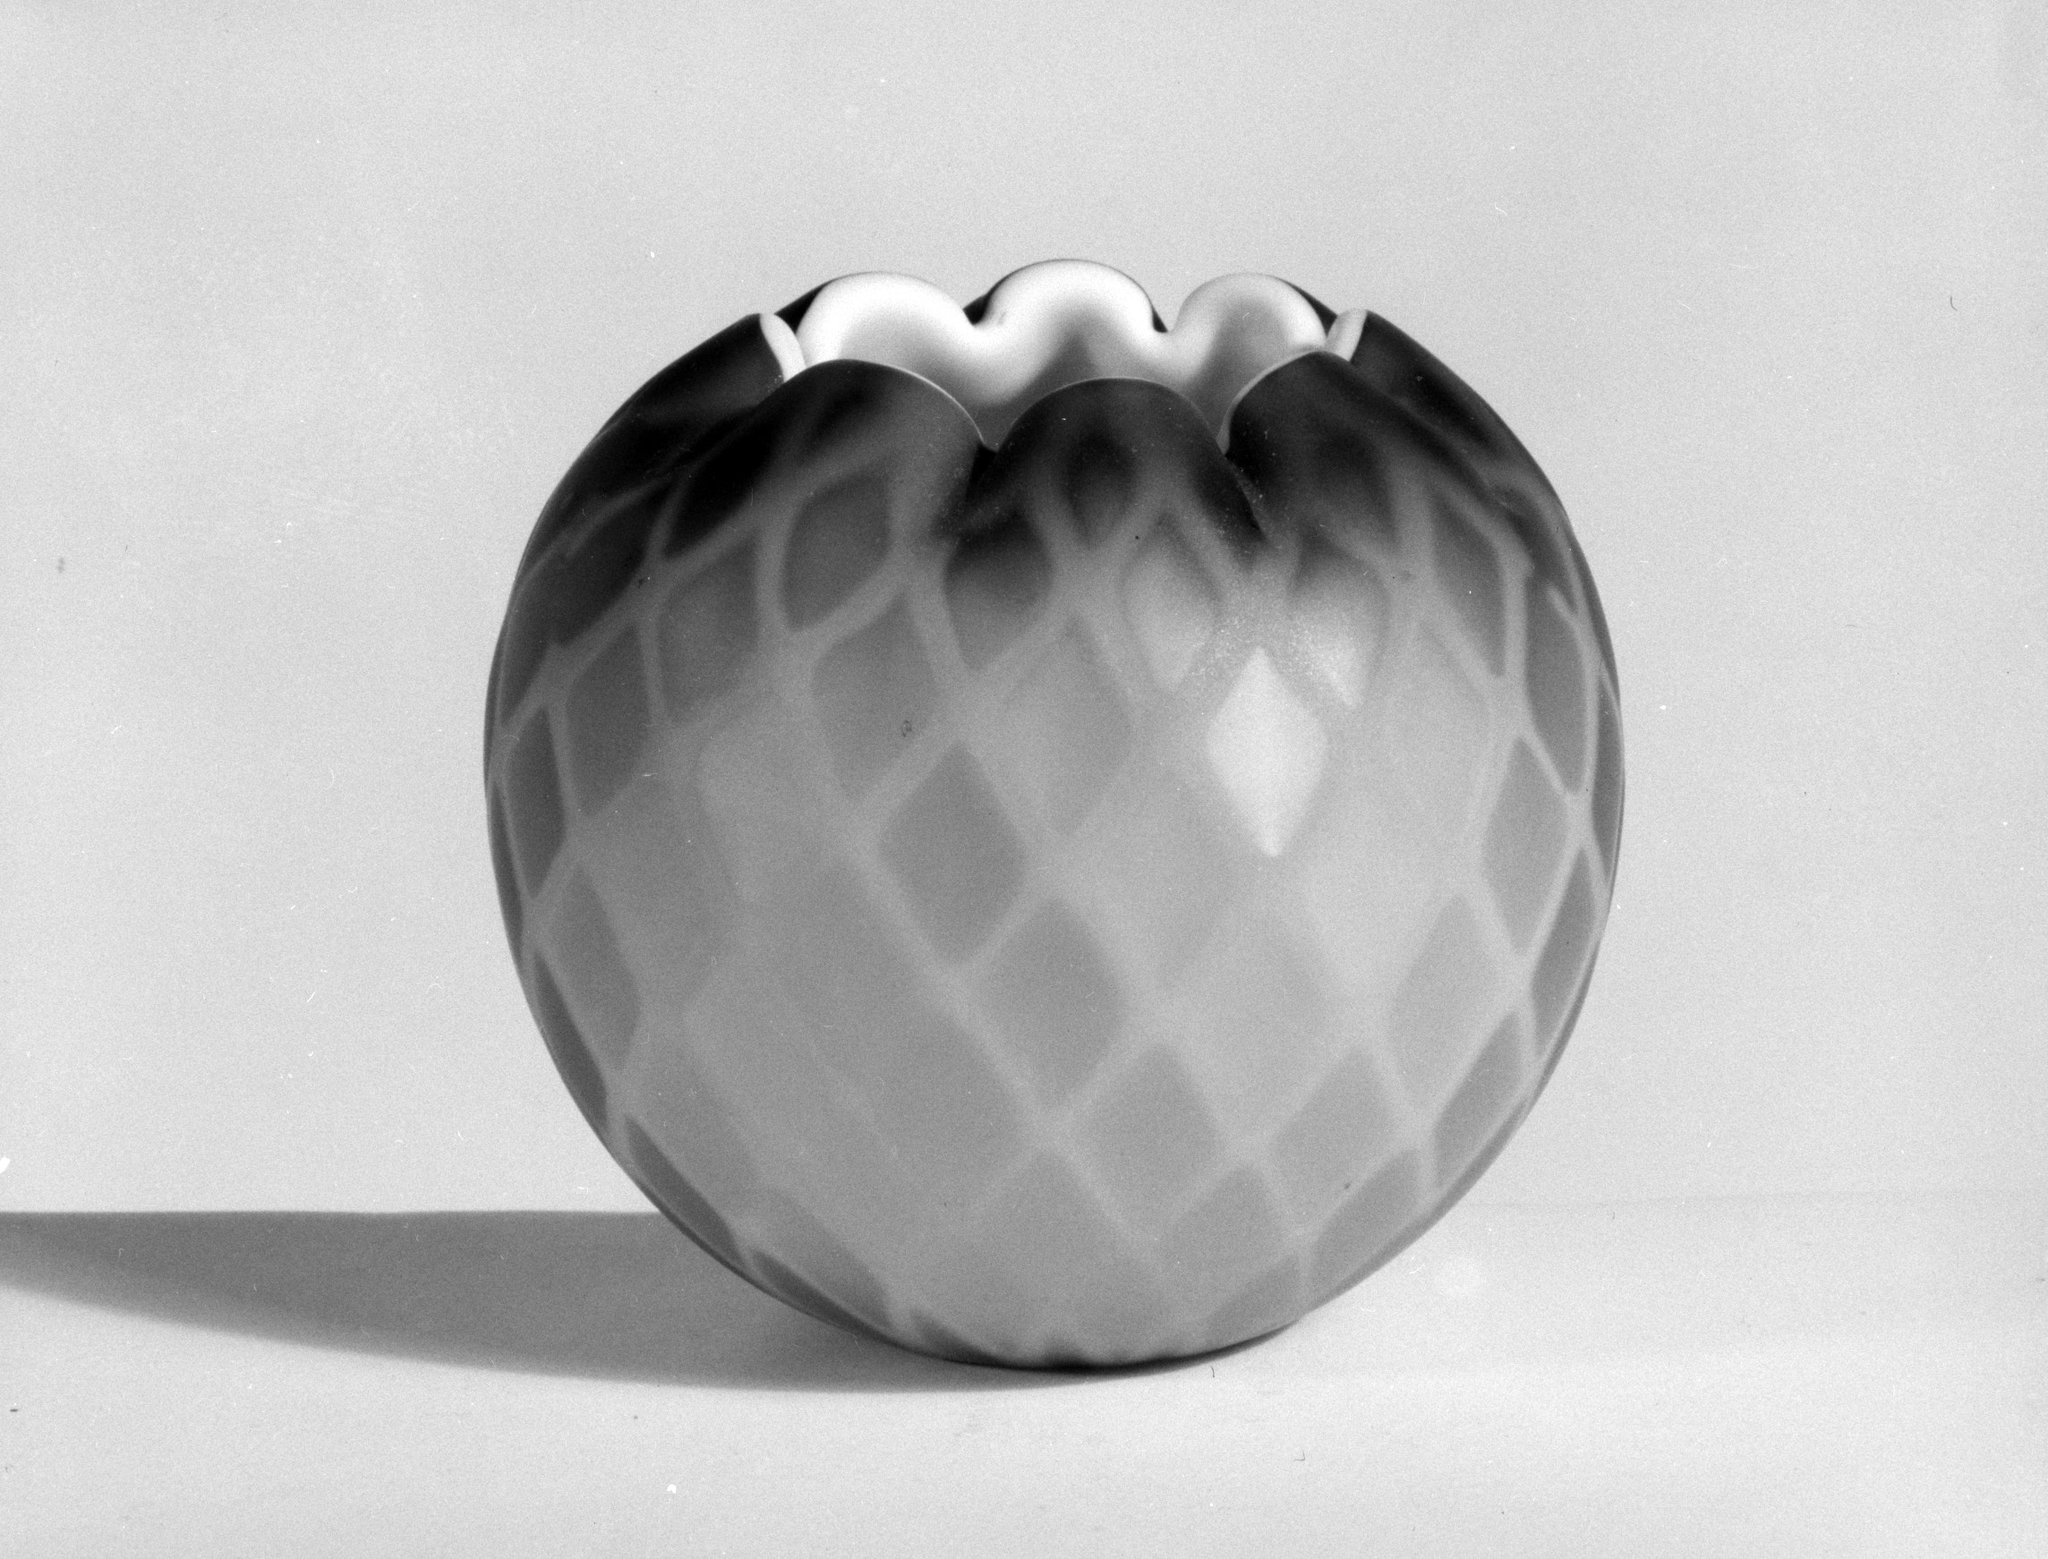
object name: bowl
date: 1885-1900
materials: glass, textile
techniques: glassblowing